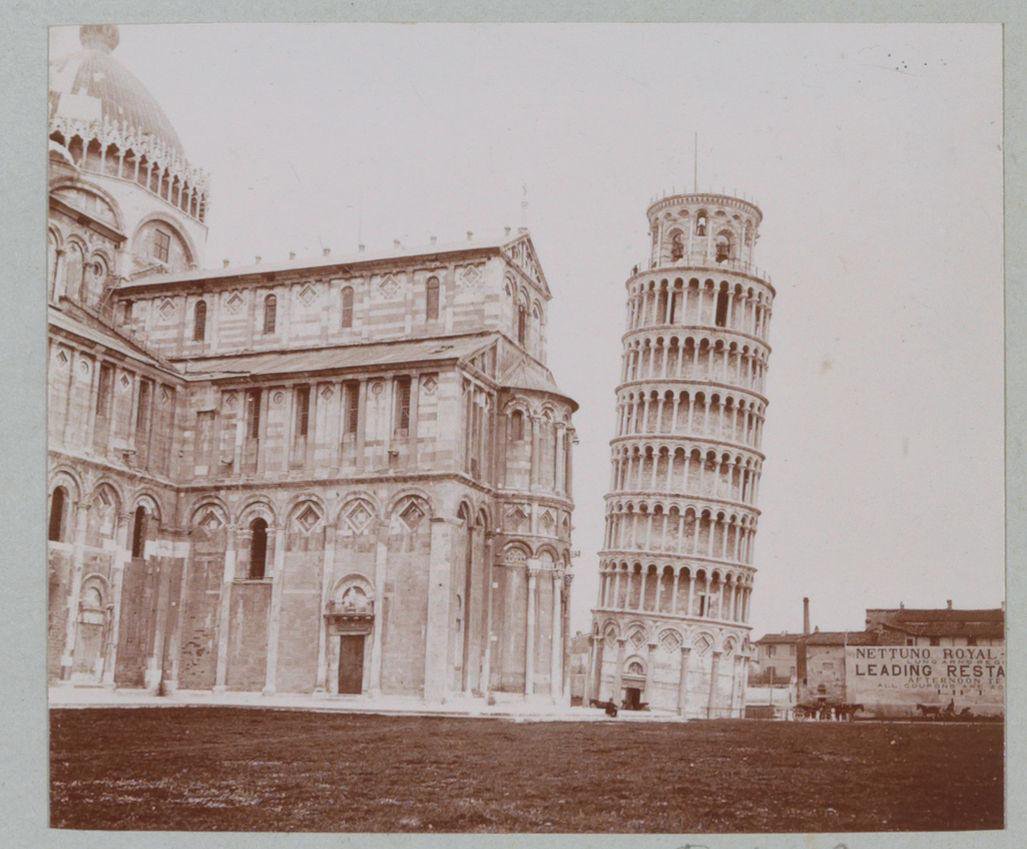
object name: photograph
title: Exterieur van de Dom en de klokkentoren ('scheve toren') van Pisa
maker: Anonymous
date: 1905-1910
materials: paper, photographic support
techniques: gelatin silver print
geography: pisa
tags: tower, clock tower ~ monumental adornment, church (exterior)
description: Onderdeel van Fotoalbum van een Franse amateurfotograaf met bezienswaardigheden in Frankrijk, Zwitserland en Italië.